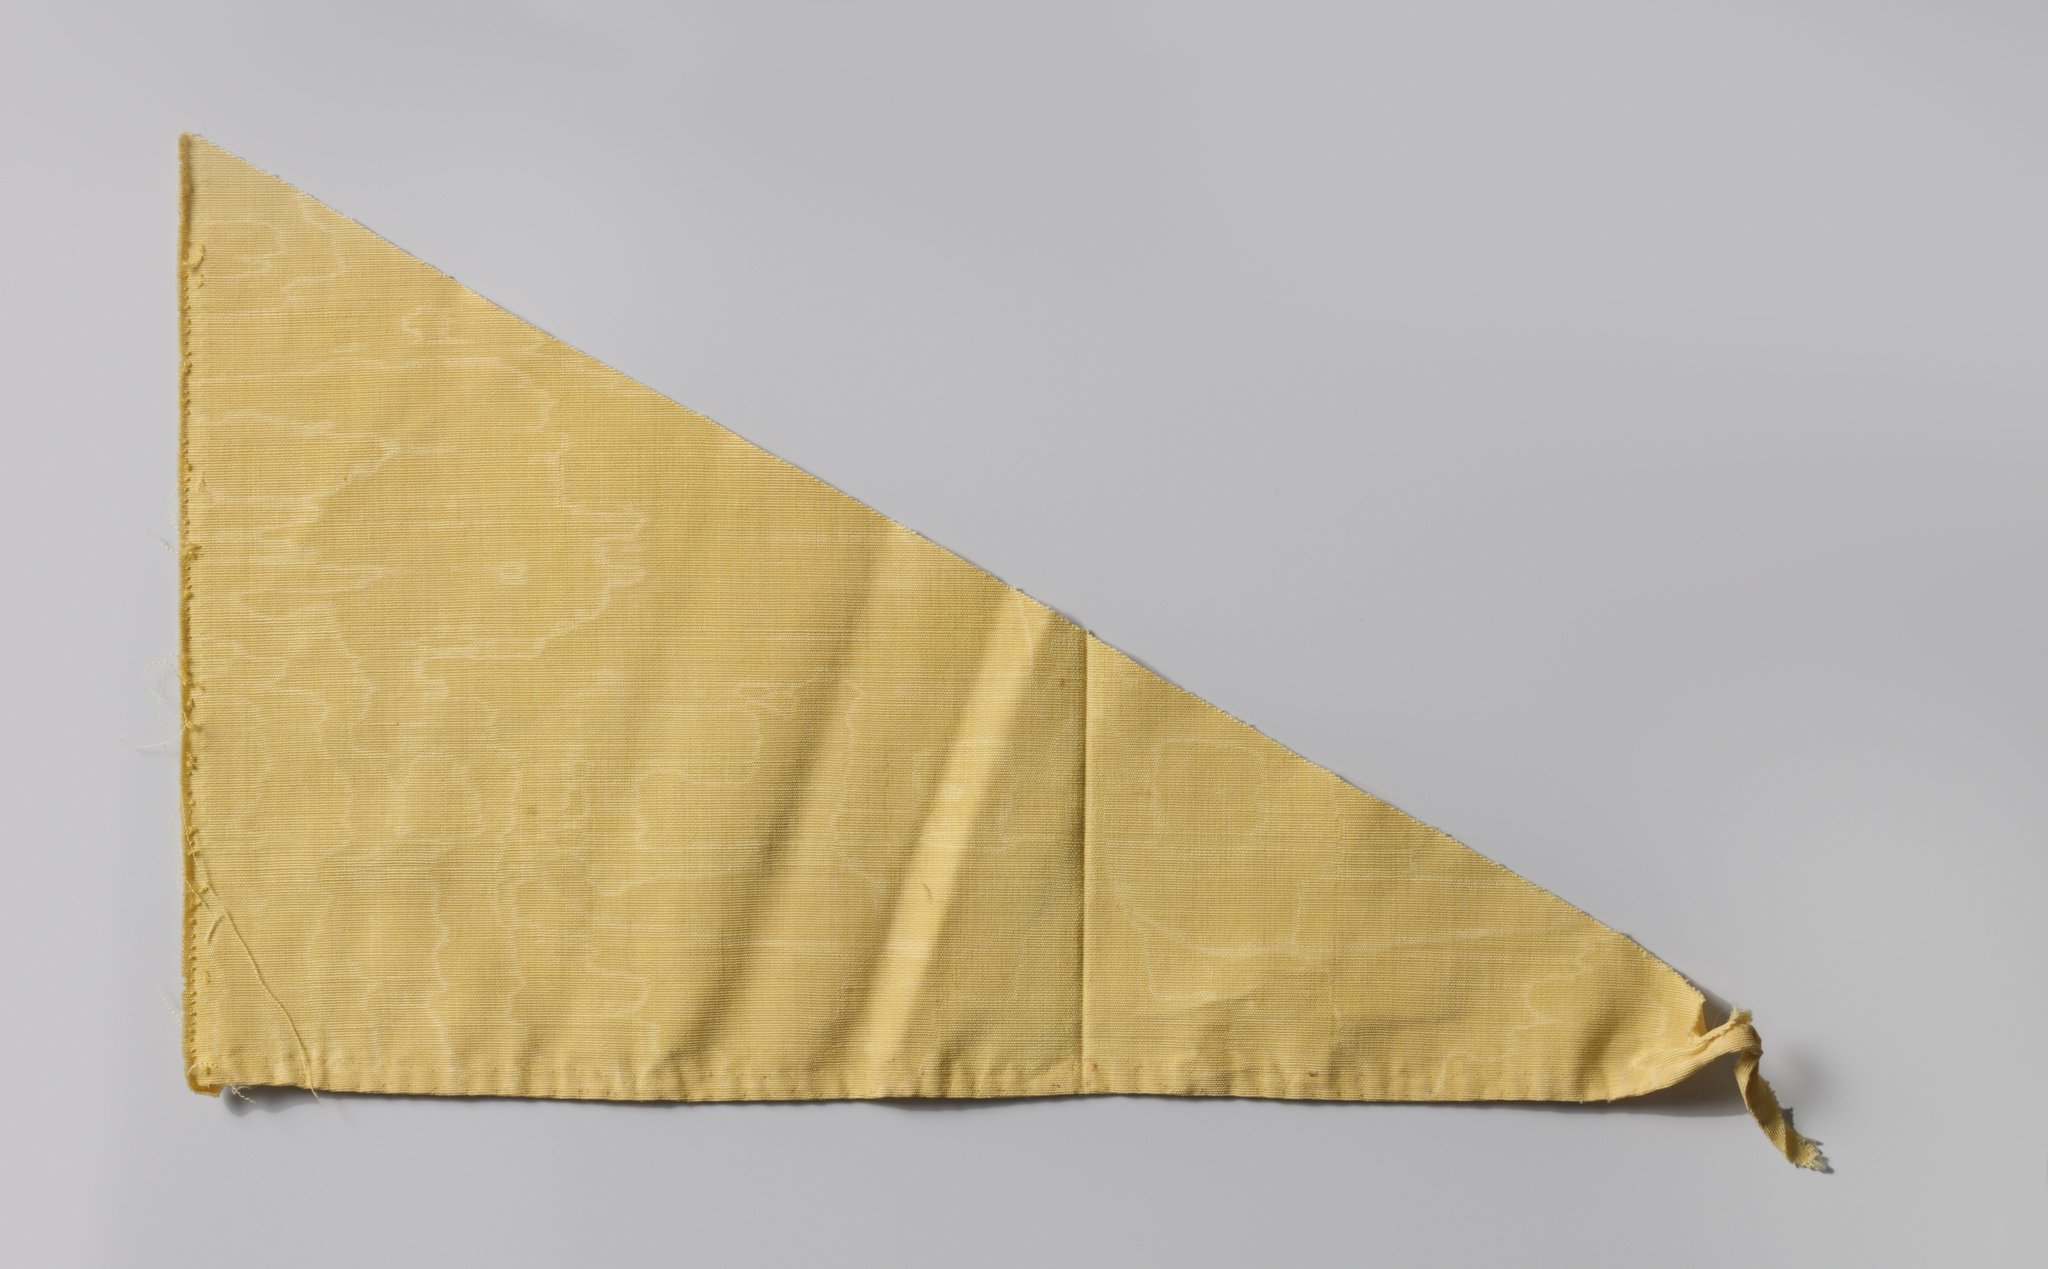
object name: fragment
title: Fragment van een bedgarnituur van gele gewaterde wol met groen passement en afhangende klosjes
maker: Anonymous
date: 1795-1815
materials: wool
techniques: moire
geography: northern netherlands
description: Fragment van een bedgarnituur van gele gewaterde wol, omboord met groen passement met een geel motief en met een groen en geel boordsel met afhangende klosjes die met gele en groene zijde zijn omwonden.